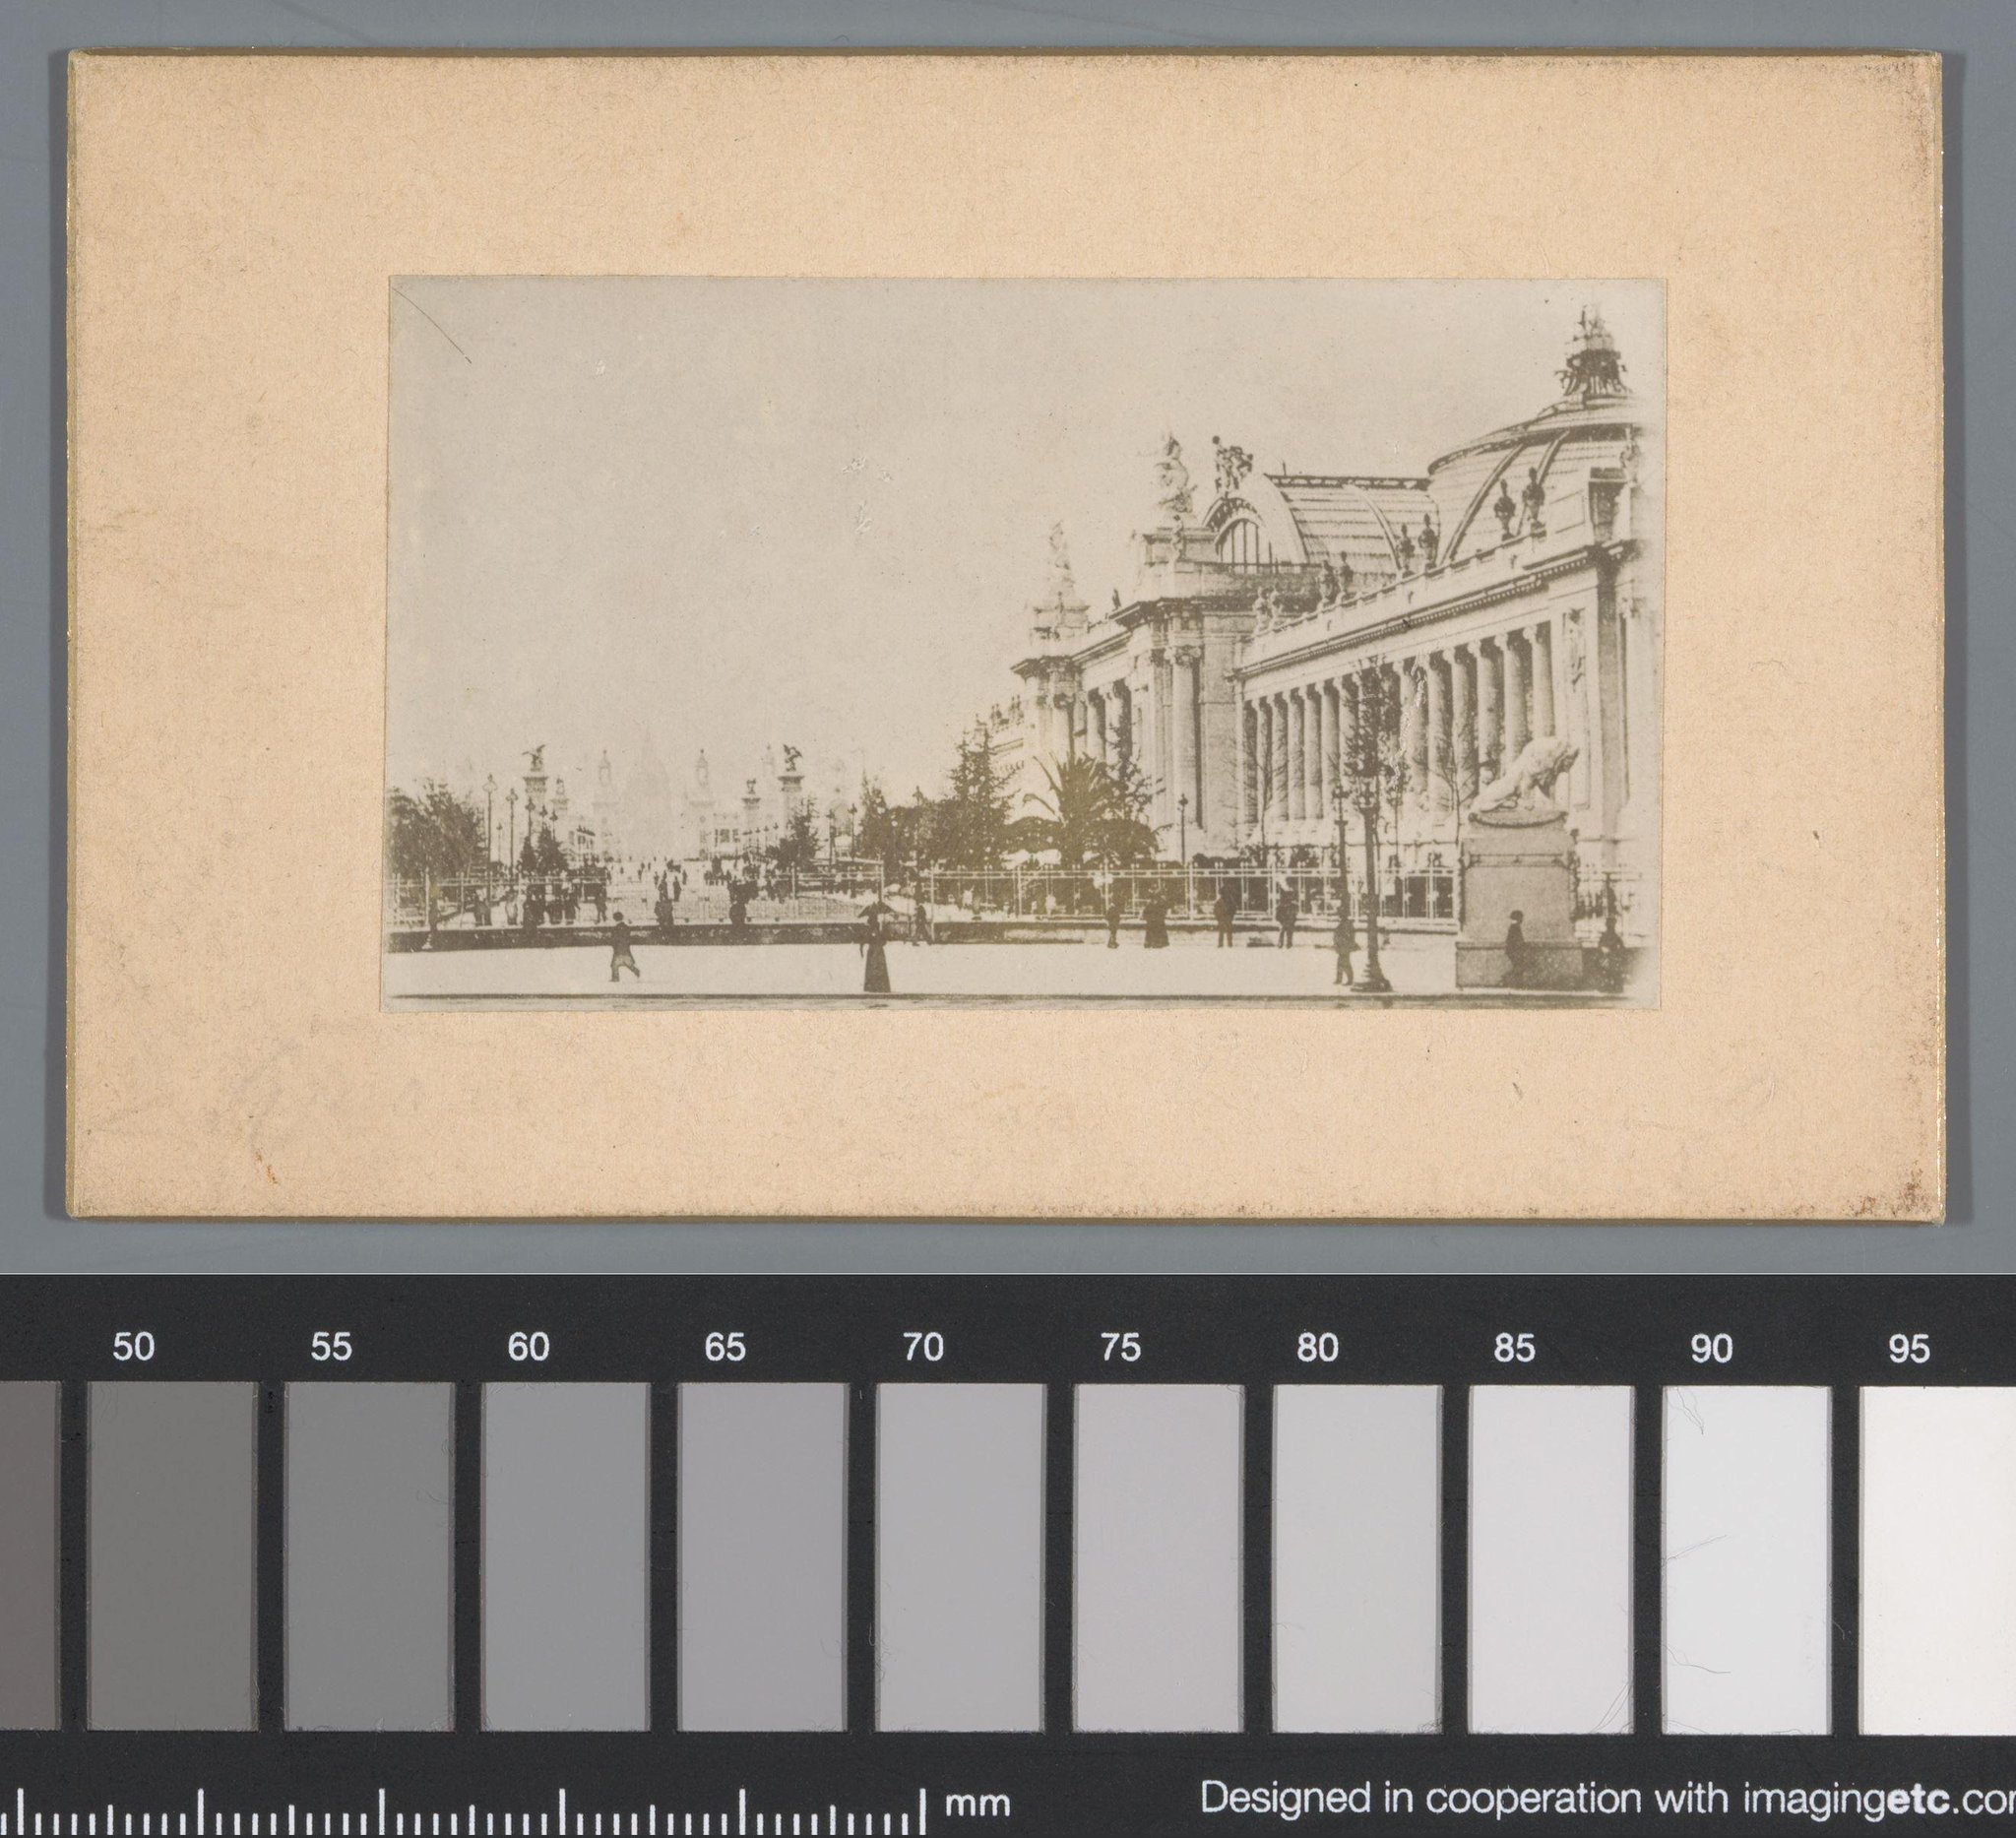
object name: carte de visite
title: Grandpalais, Paris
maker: Anonymous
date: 1900-1910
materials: cardboard, photographic support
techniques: matte daylight collodion silver print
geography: paris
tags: world fair, world exhibition, palace